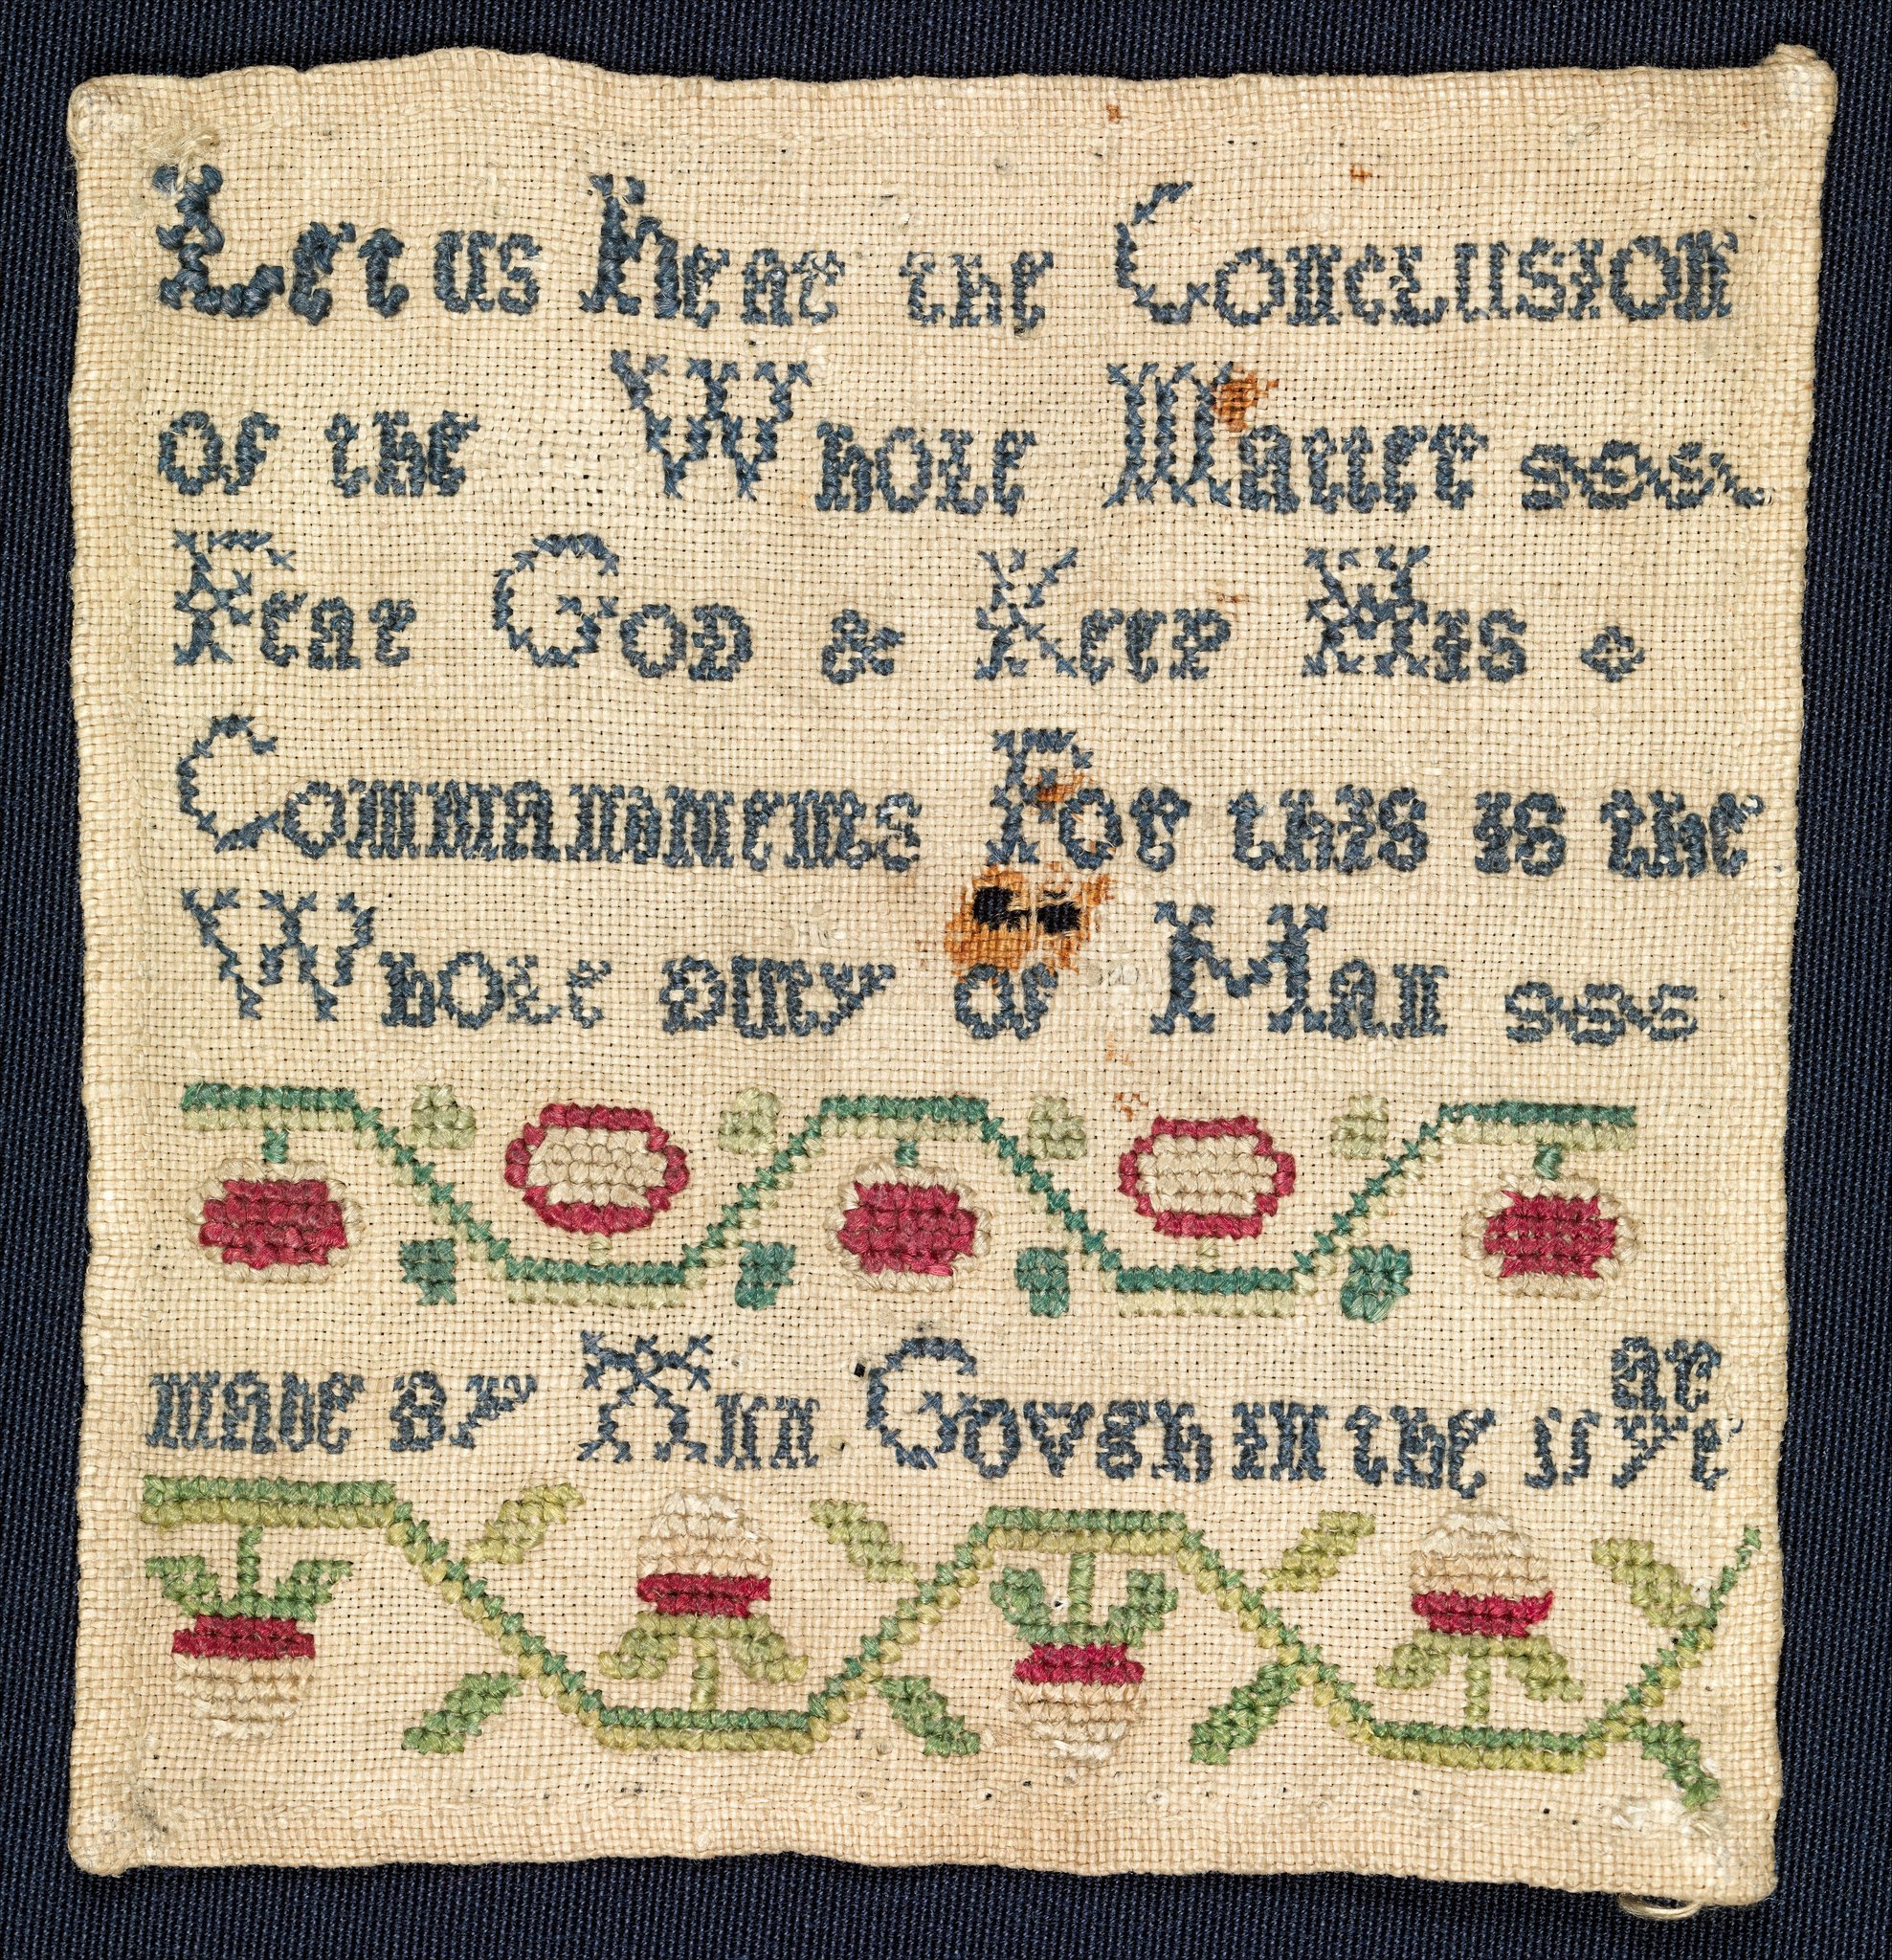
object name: sampler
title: Sampler made at a charity school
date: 1801-1900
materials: linen, silk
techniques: embroidery